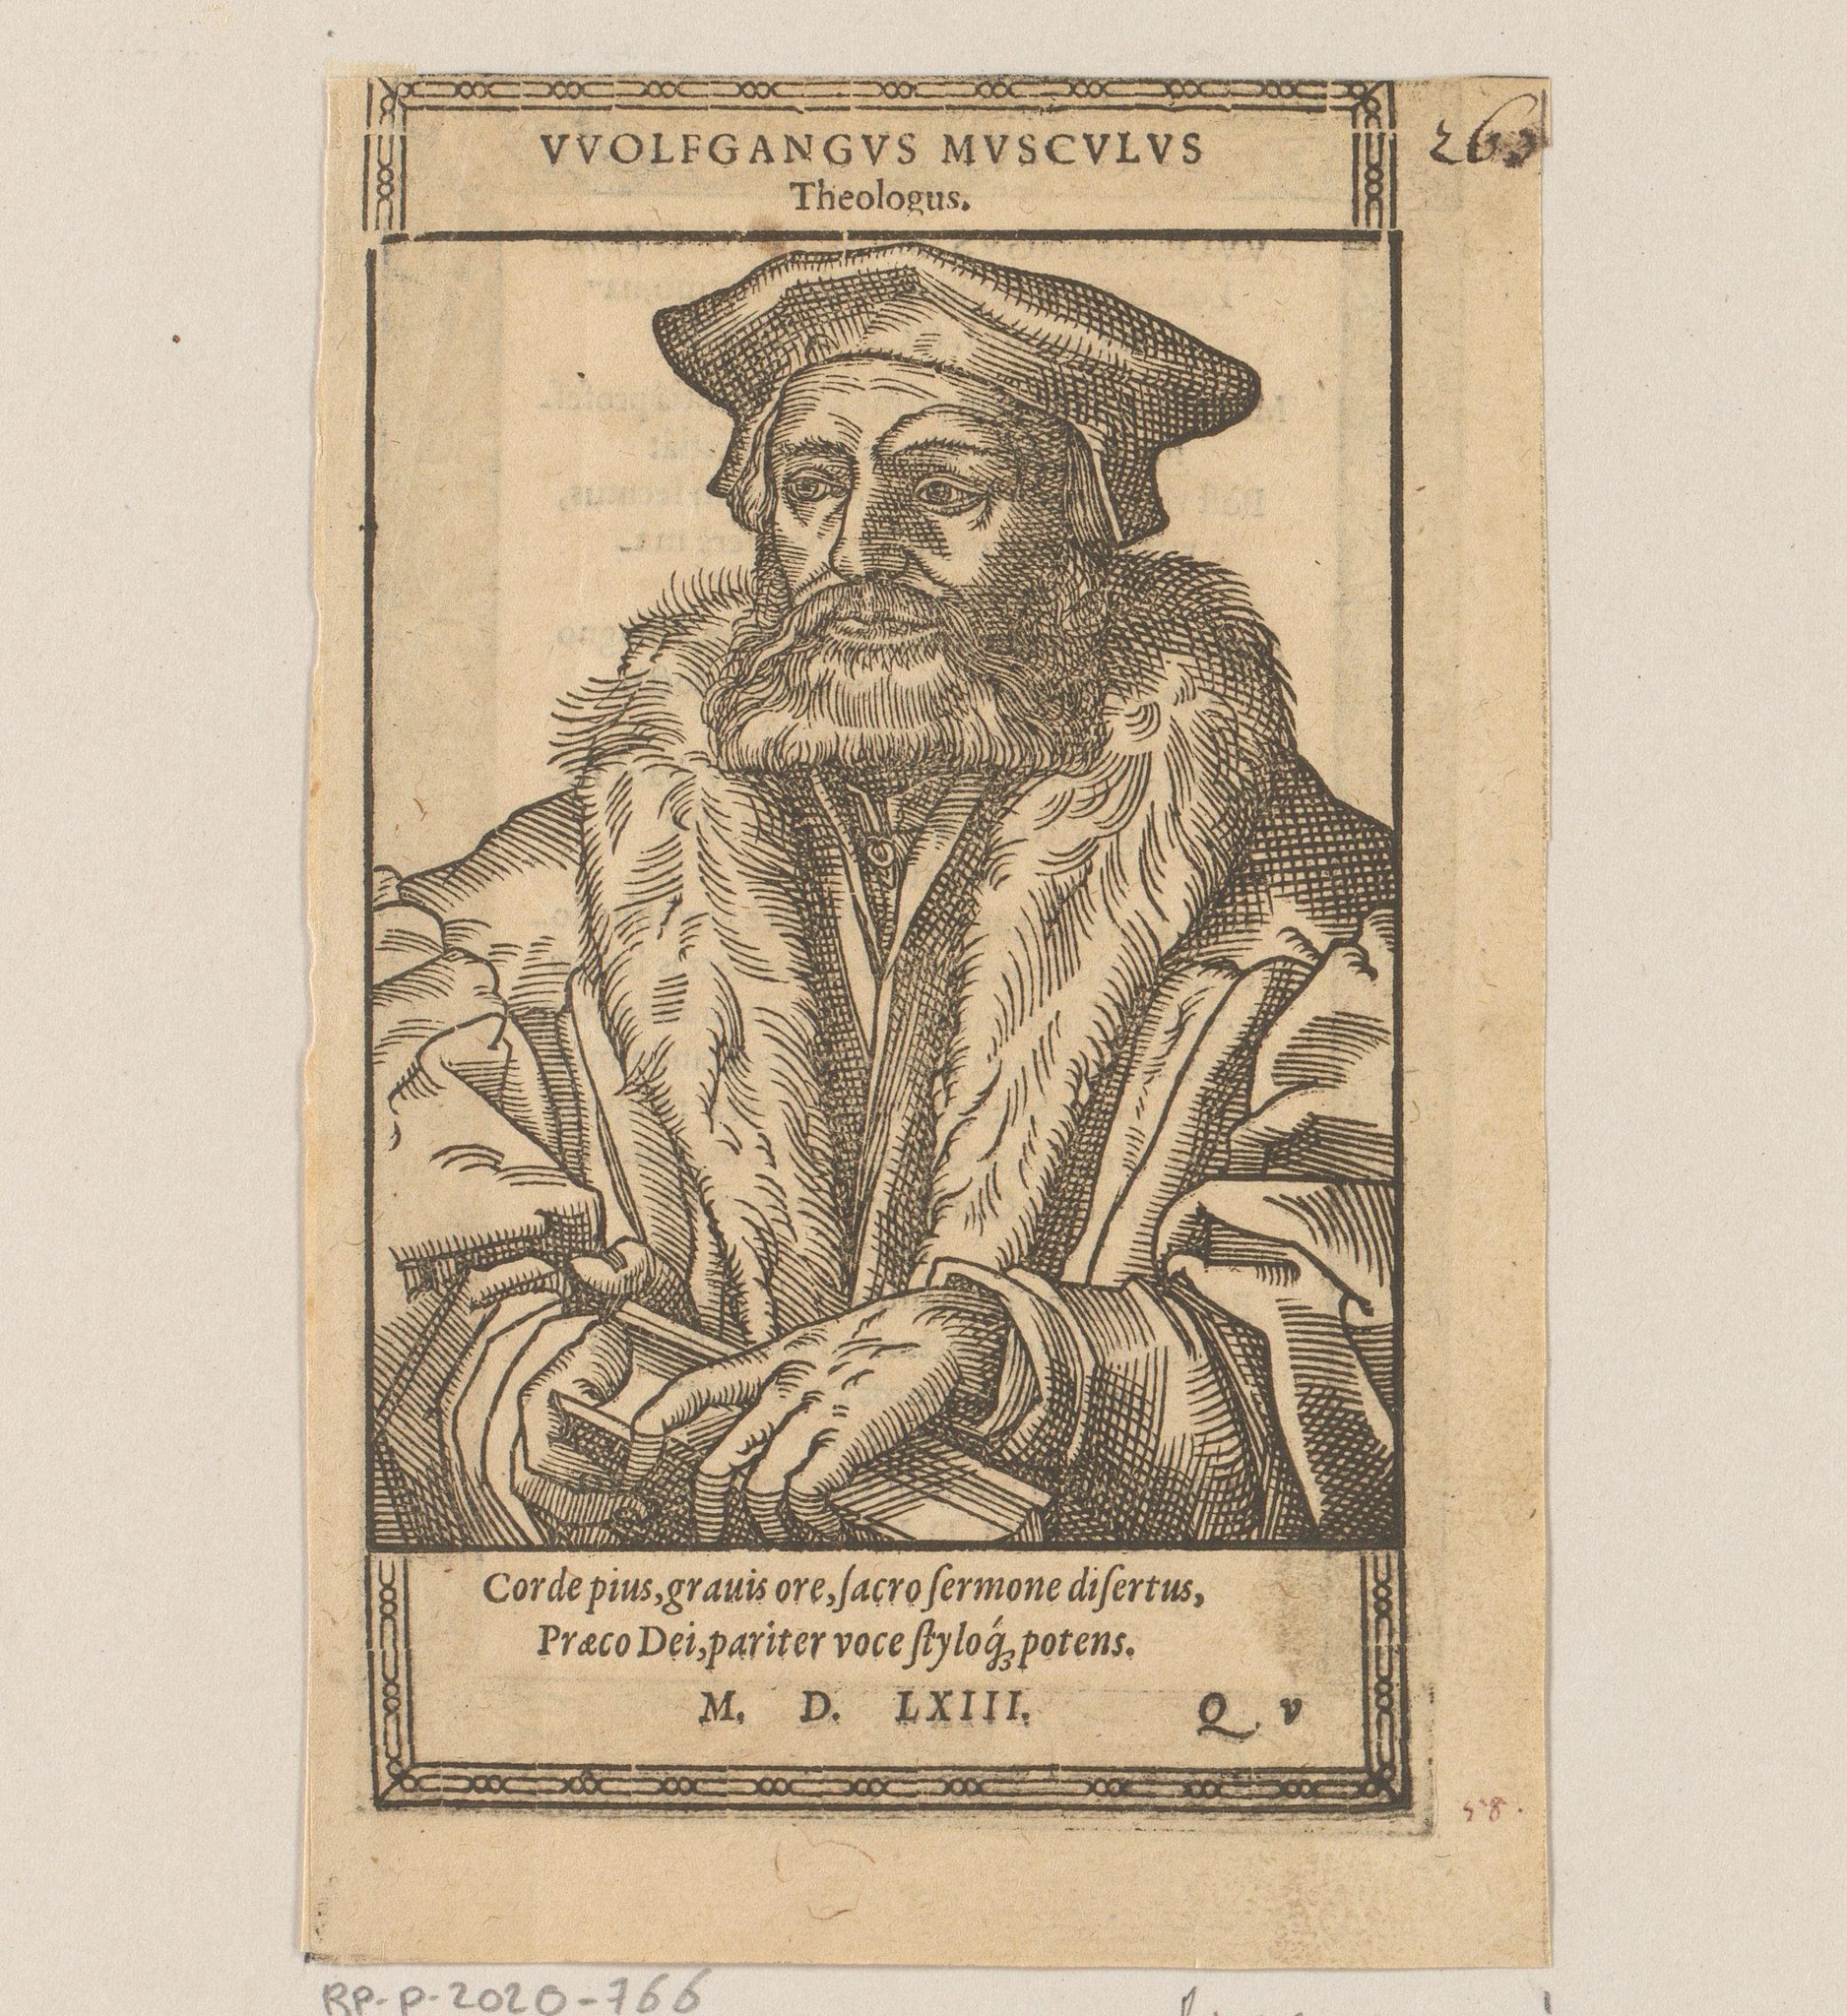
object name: print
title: Portret van Wolfgang Musculus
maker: bernhard jobin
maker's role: printer, publisher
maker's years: 1545-1593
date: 1587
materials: paper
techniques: letterpress printing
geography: straatsburg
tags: theologian, historical persons, book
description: Prent uit: Reusner, Nikolaus. Icones sive imagines virorum literis illustrium (...). Straatsburg: Bernhard Jobin, 1587. Prent ook gebruikt in de Duitse editie, uitgegeven in hetzelfde jaar, en de 1590-editie. Prent ook gebruikt in latere publicaties.